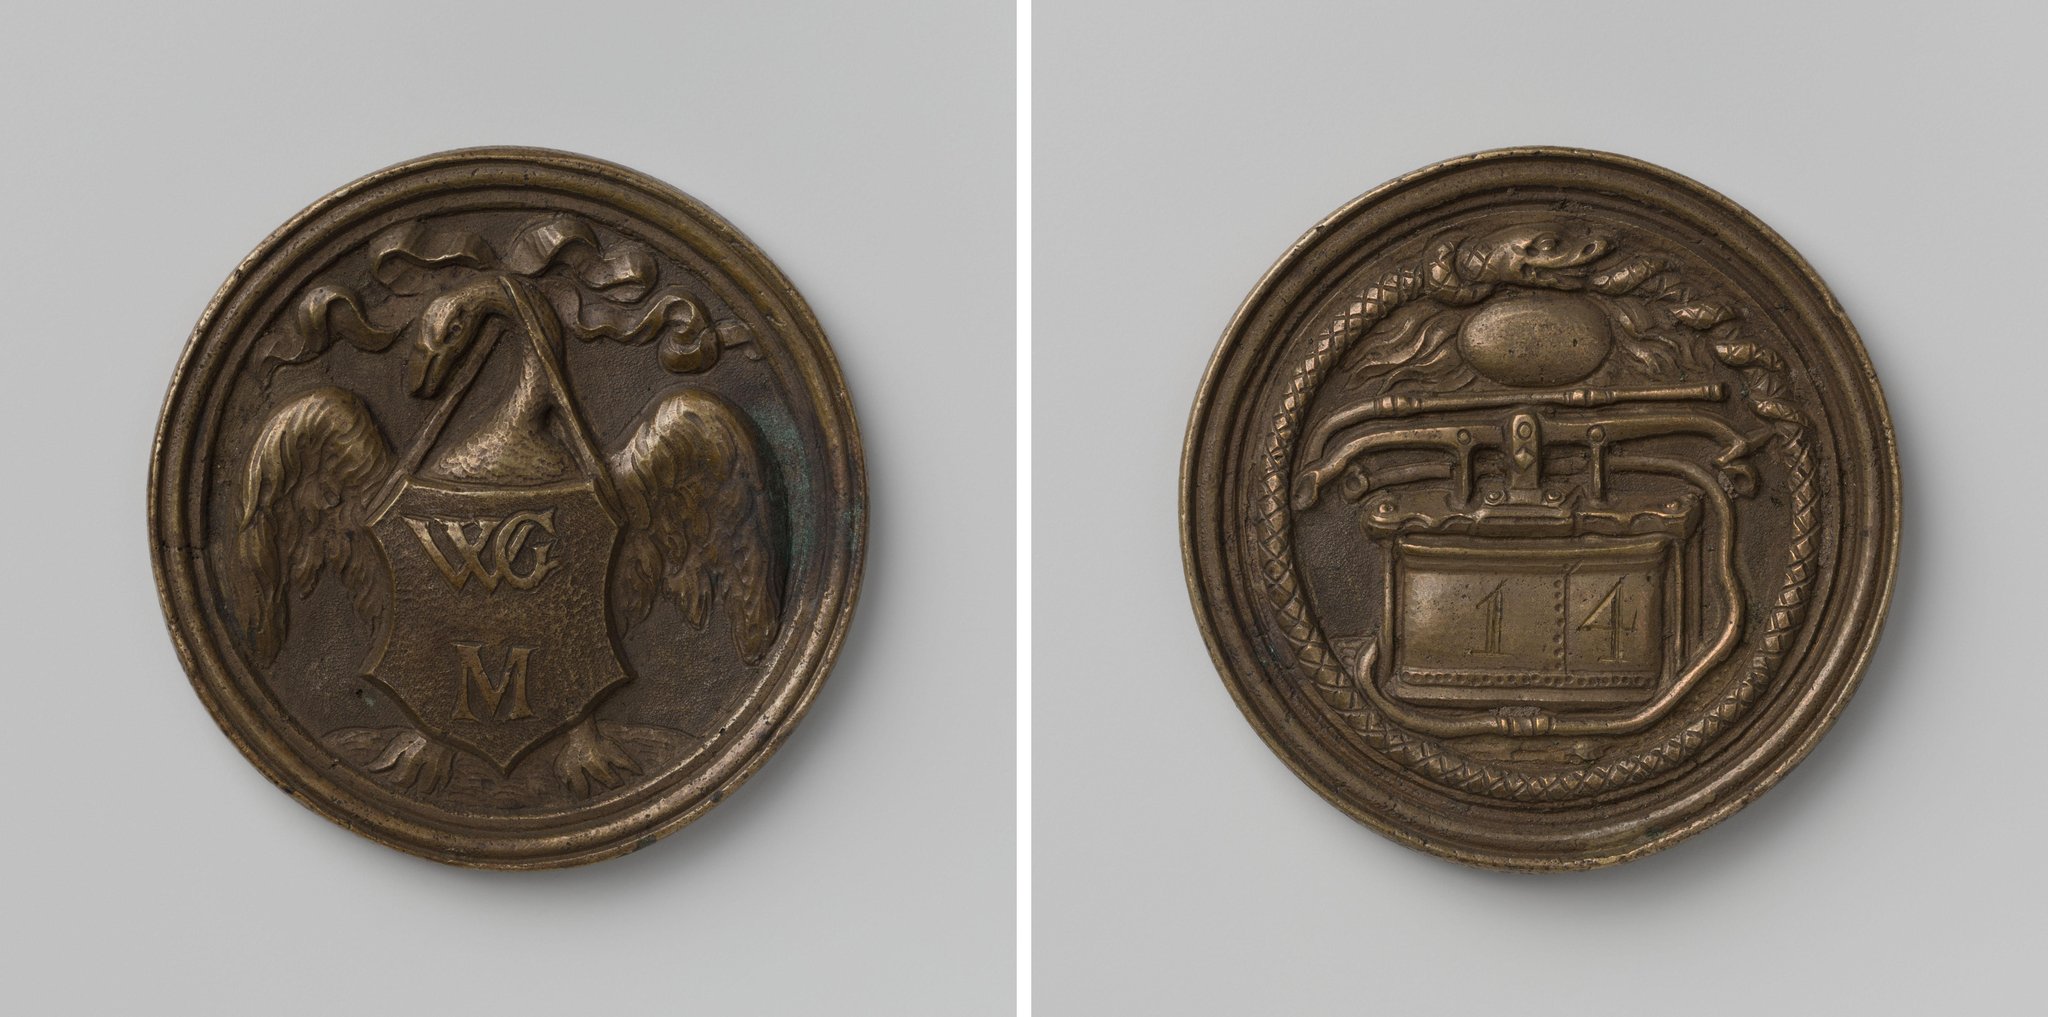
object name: fire engine medal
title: Watergraafsmeer, brandspuitpenning met no. 14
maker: Anonymous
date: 1680-1800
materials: brass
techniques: casting, engraving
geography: amsterdam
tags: watergraafsmeer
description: Messing penning. Voorzijde: zwaan met uitgespreide vleugels draagt wapenschild dat met lint om zijn nek hangt. Keerzijde: brandspuit onder leeg cartouche binnen slangerond; op zijde van brandspuit: cijfer 14